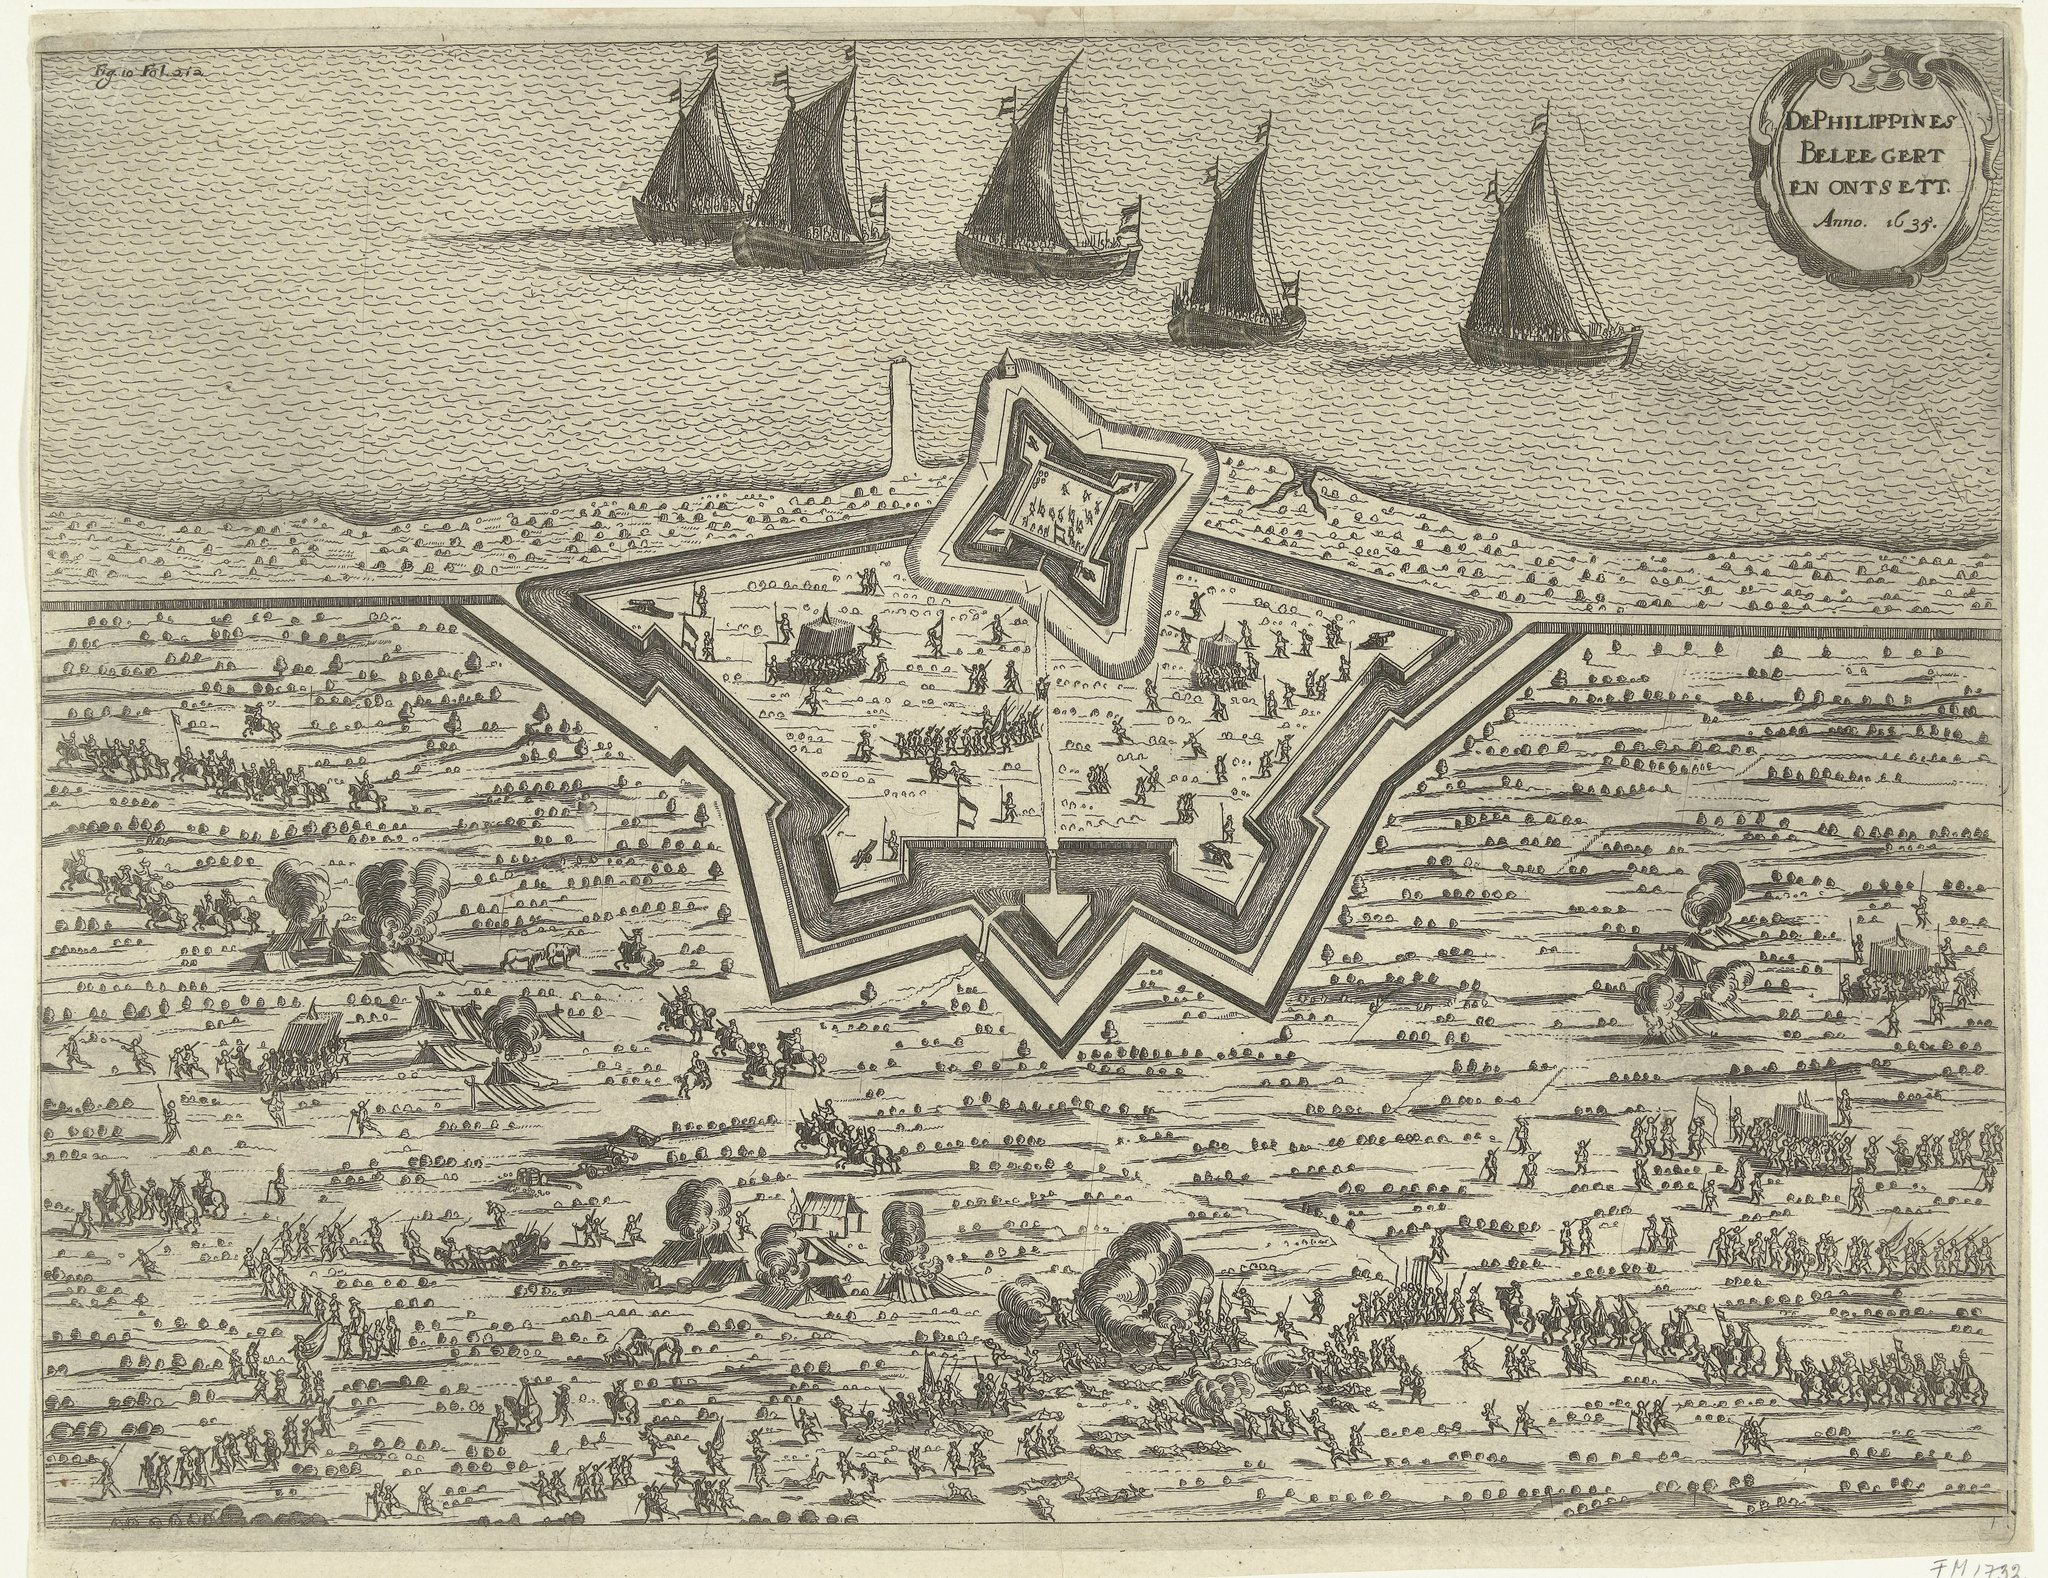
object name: print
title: De Philippines beleegert en ontsett. Anno 1635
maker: Anonymous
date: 1651-1652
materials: paper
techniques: etching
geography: northern netherlands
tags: delft, the hague, frederick henry (prince of orange), siege, position war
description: De belegering door het Spaanse leger en het ontzet door het Staatse leger onder Frederik Hendrik van het fort Philippines (Fort Sint-Philips) in Vlaanderen op de oever van de Schelde op 20 mei 1635. Plattegrond van het fort aan de oever, op het land een legerkamp en oprukkende cavalerie. Boven in het water vijf Hollandse schepen. Gemerkt linksboven: Fig. 10. Fol. 212.